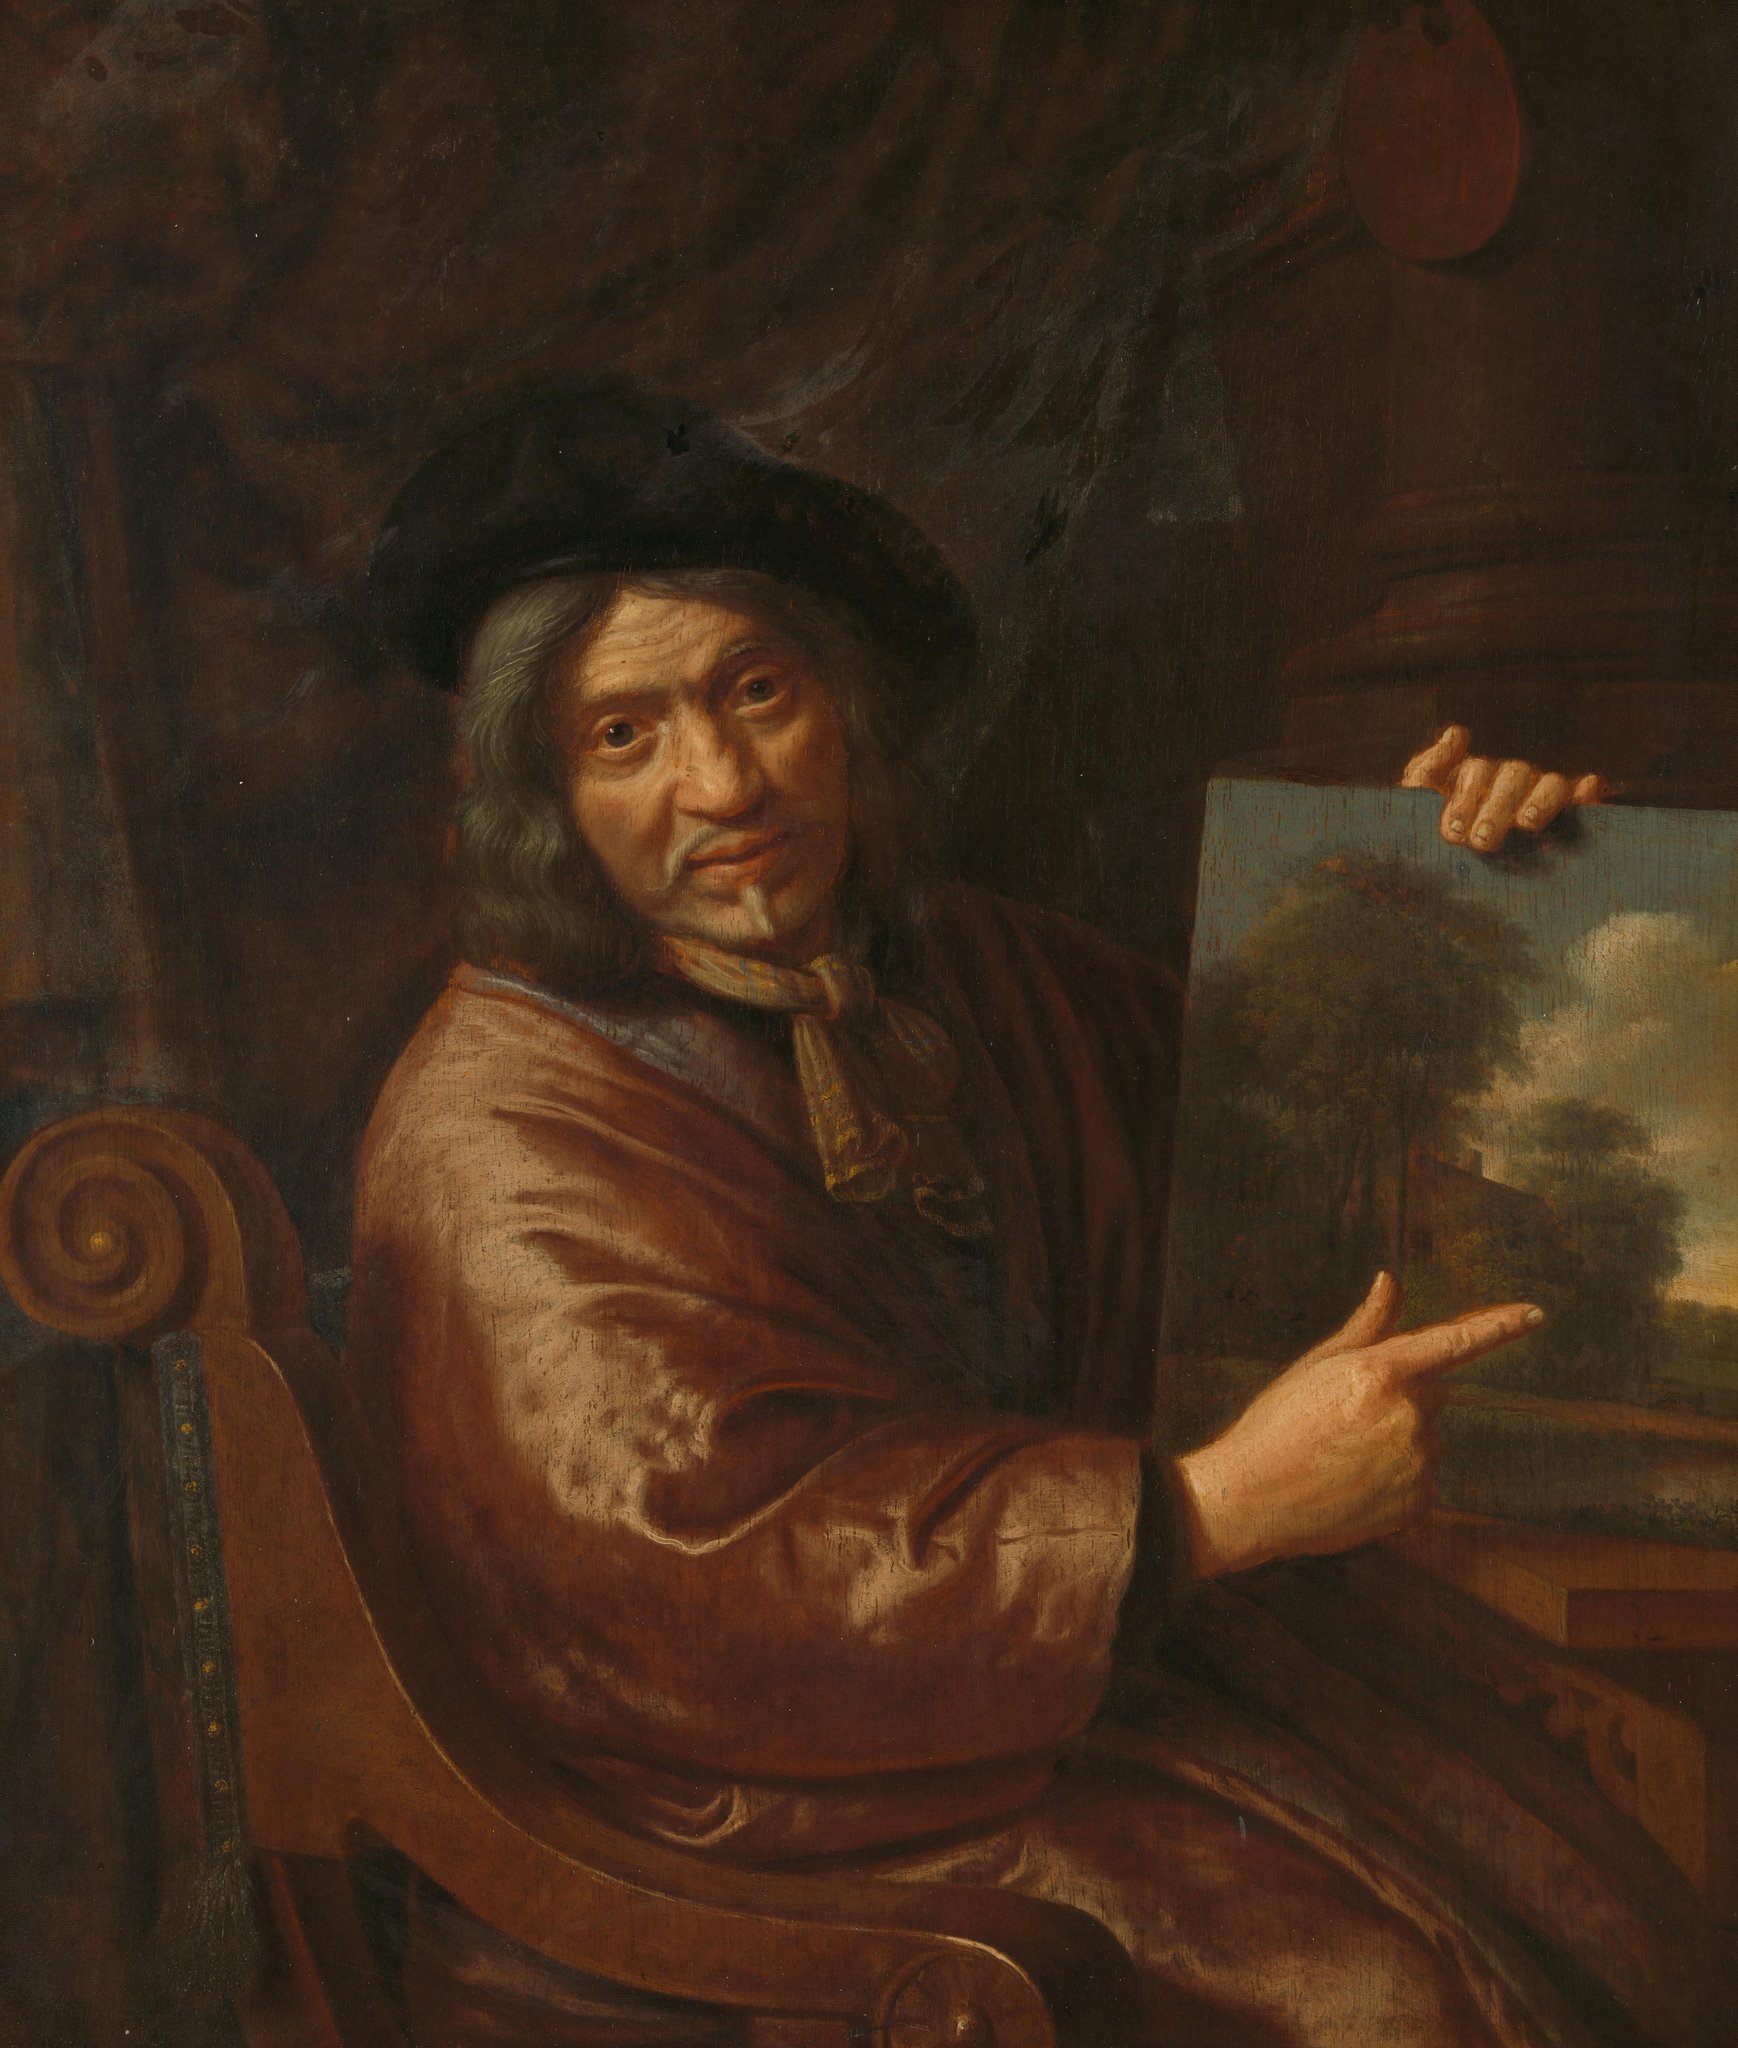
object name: painting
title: Self-Portrait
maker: pieter jansz van asch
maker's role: draughtsman, painter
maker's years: 1603-1678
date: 1660-1678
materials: oil, panel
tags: pieter jansz van asch, portrait, self-portrait of painter, portrait, self-portrait of artist, picture, painting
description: Zelfportret van de schilder Pieter Jansz. van Asch zittend in een leunstoel en wijzend op een schilderij dat hij op de tafel voor hem houdt.